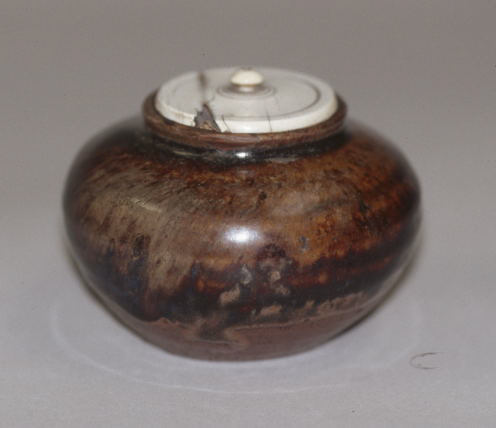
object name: tea jar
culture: japanese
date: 1701-1800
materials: clay, glaze